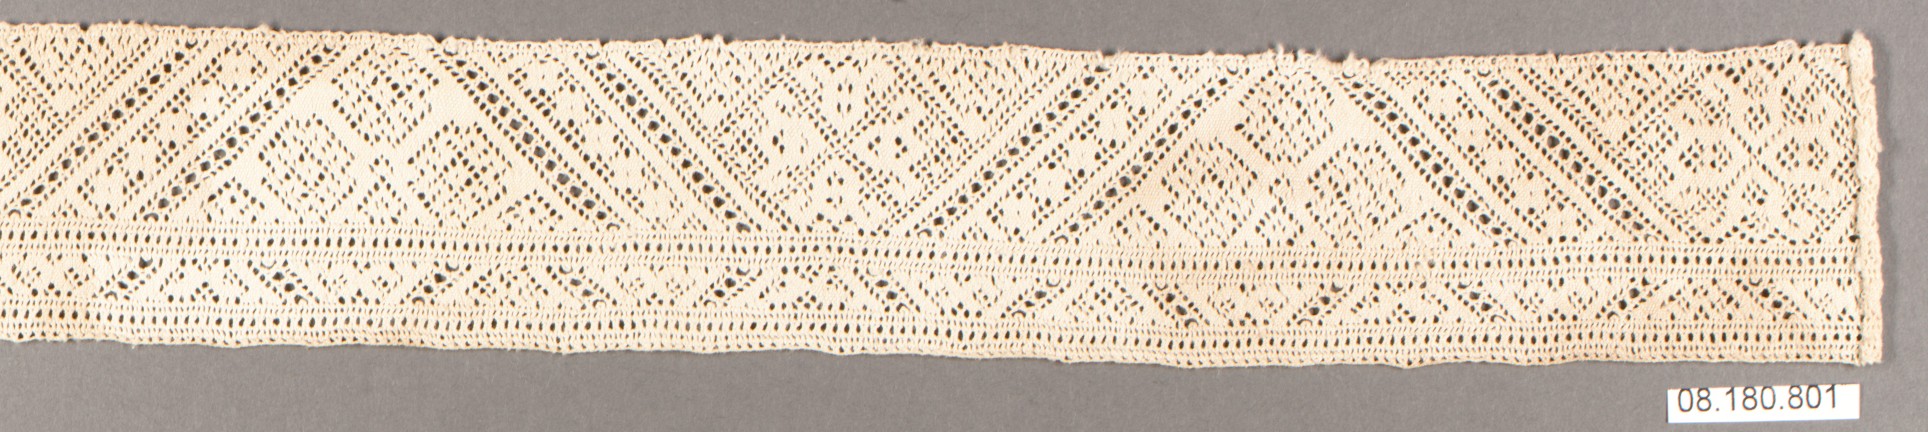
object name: fragment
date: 1701-1800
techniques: lace